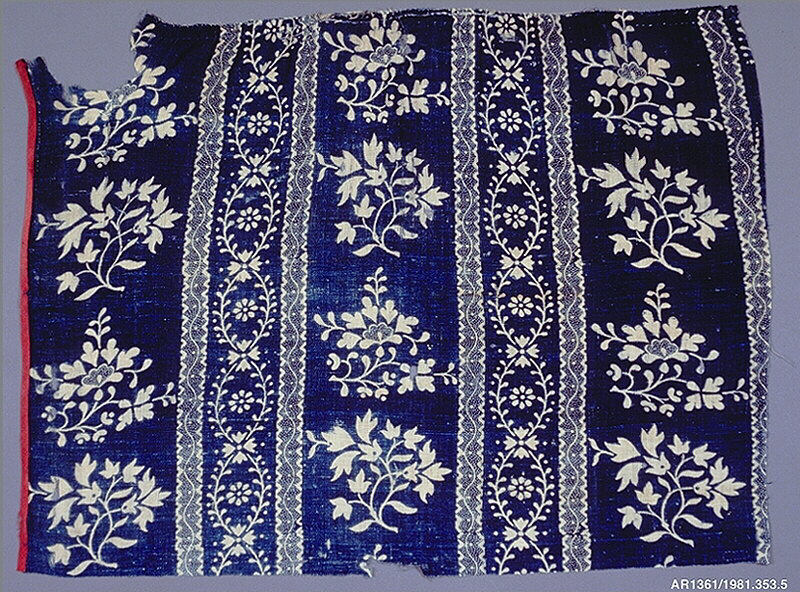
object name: piece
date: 1701-1800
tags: flowers,leaves